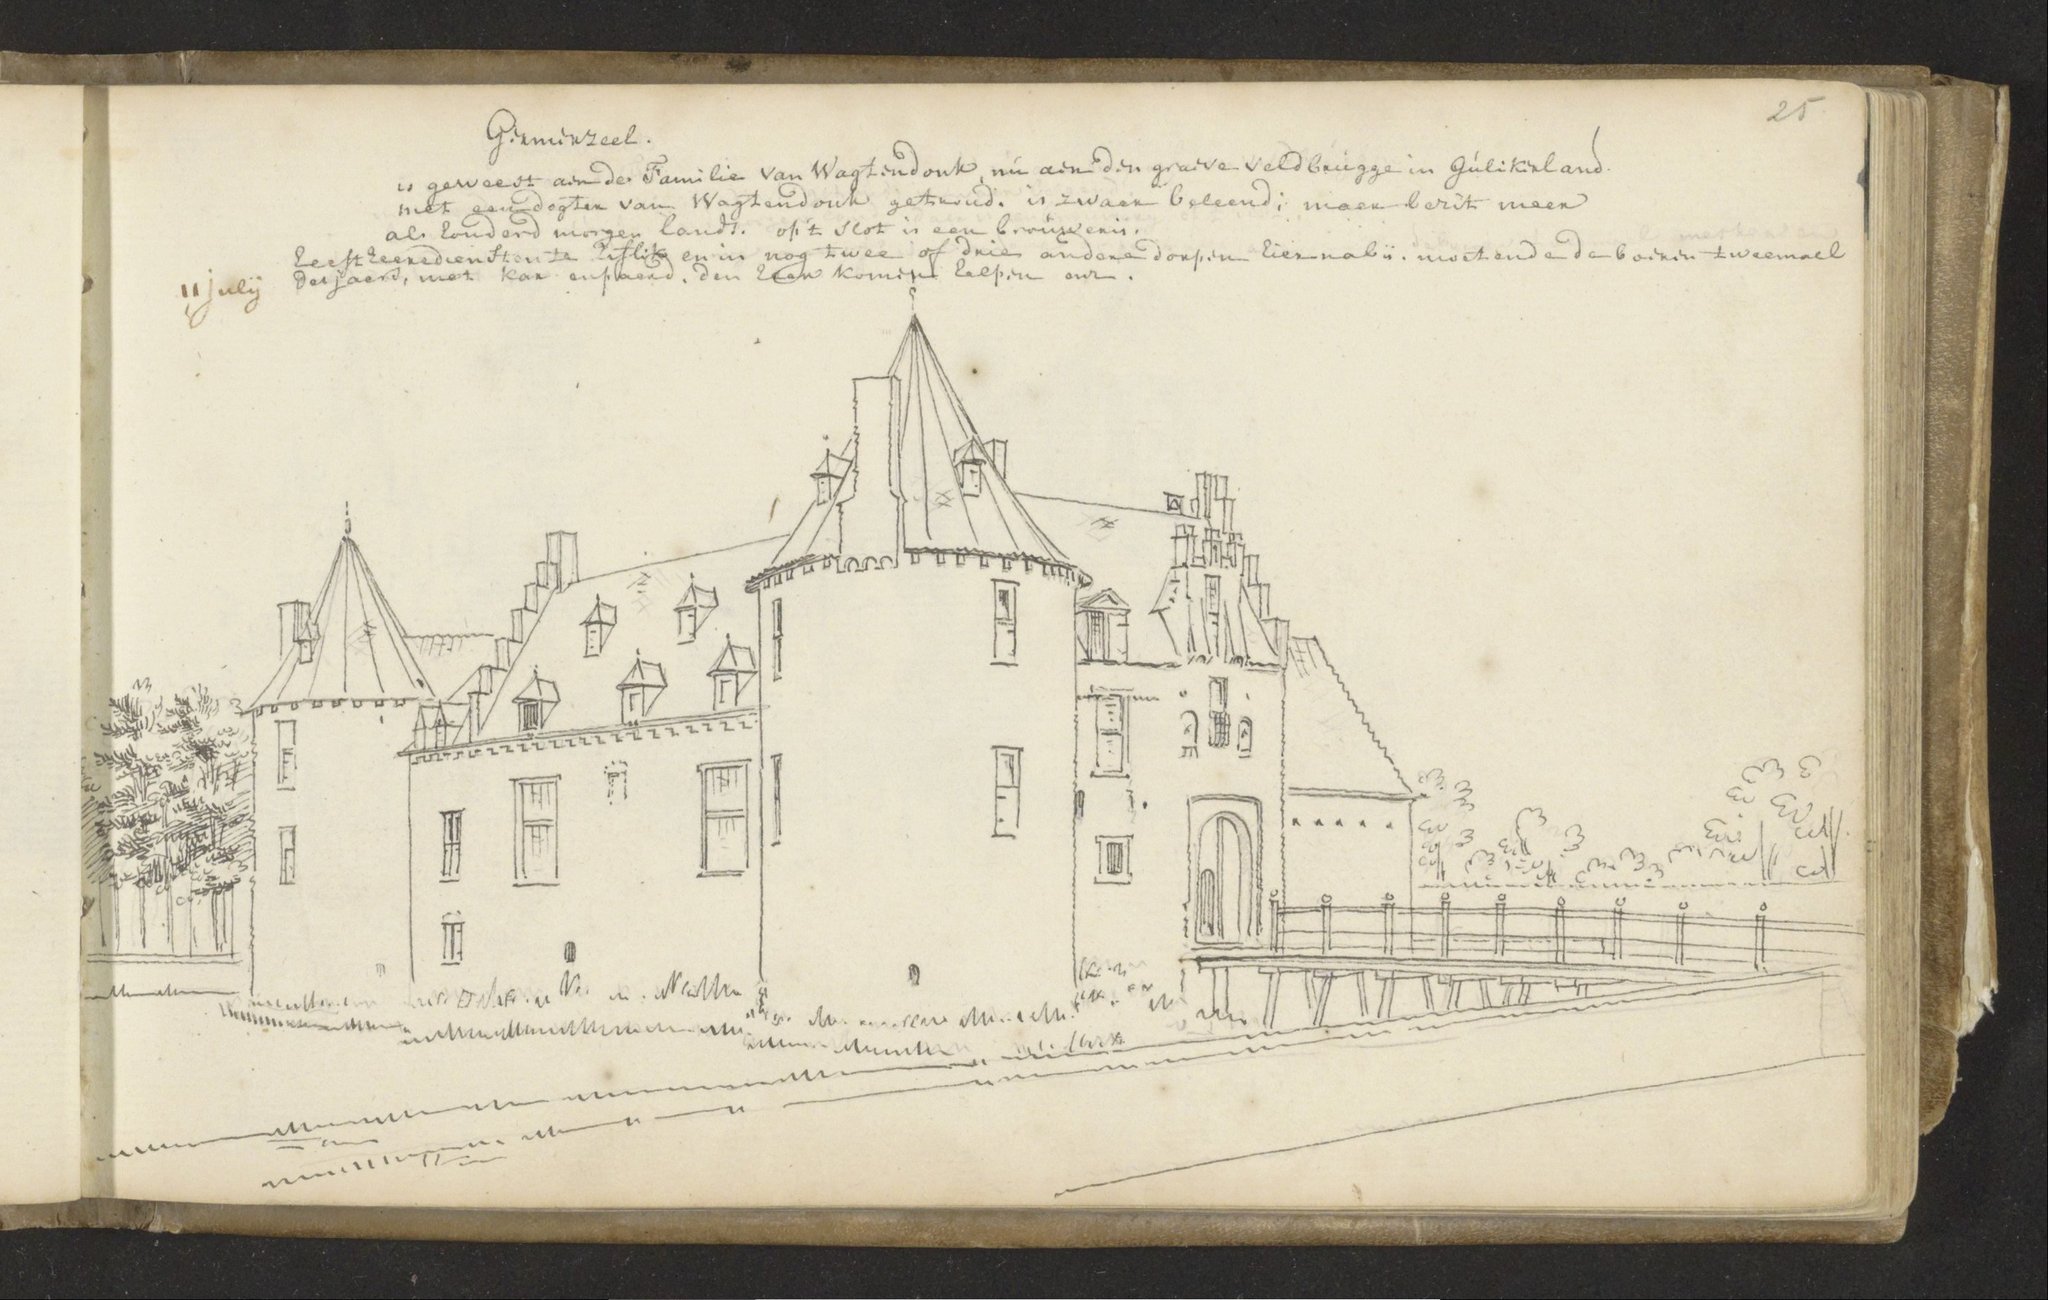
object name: sketchbook leaf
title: Kasteel Germerzeel in Duitsland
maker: abraham de haen (ii)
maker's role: draughtsman, print maker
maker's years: 1707-1748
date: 1731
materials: ink, paper, pencil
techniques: brush, pen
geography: germerzeel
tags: castle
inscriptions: annotation: ‘Germerzeel./ is geweest van de familie ...’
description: Blad 25 recto uit een schetsboek met 69 bladen.